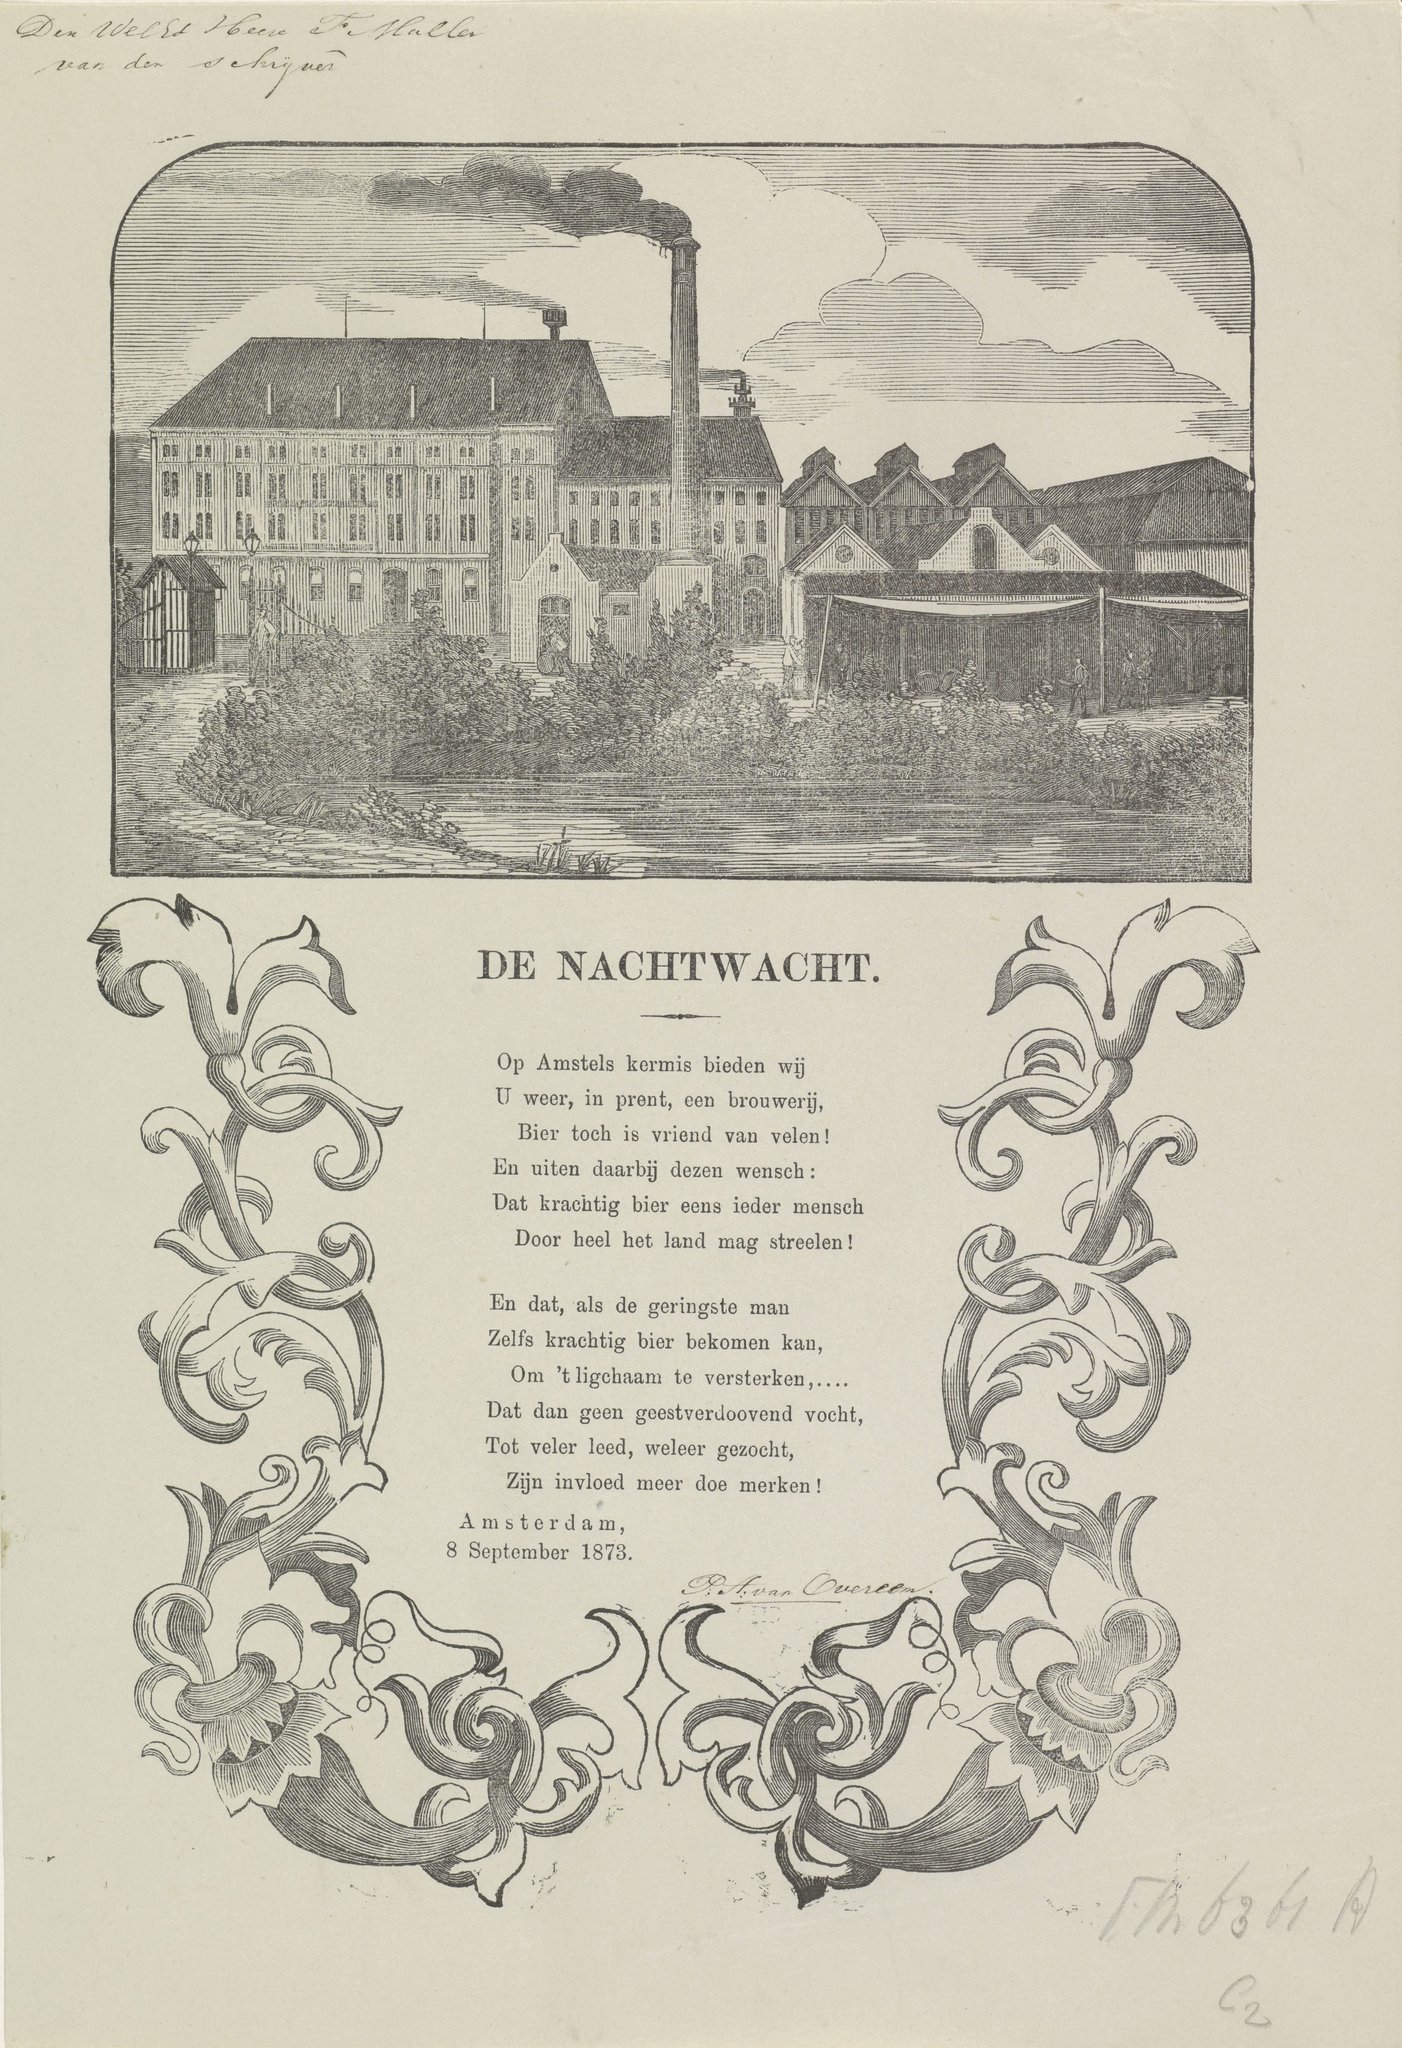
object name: print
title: De Nachtwacht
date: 1873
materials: paper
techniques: letterpress printing, engraving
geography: amsterdam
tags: brewer, night patrol, industries ~ food, drink, stimulants (+ place ~ crafts, industries, agriculture), amsterdam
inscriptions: collector's mark: Lugt 2228, inscription: ‘Den WelEd Heer F Muller / van den schrijver’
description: Kermisprent van de Amsterdamse nachtwacht, 8 september 1873. Centraal een gedicht, daarboven een gezicht op een brouwerij.